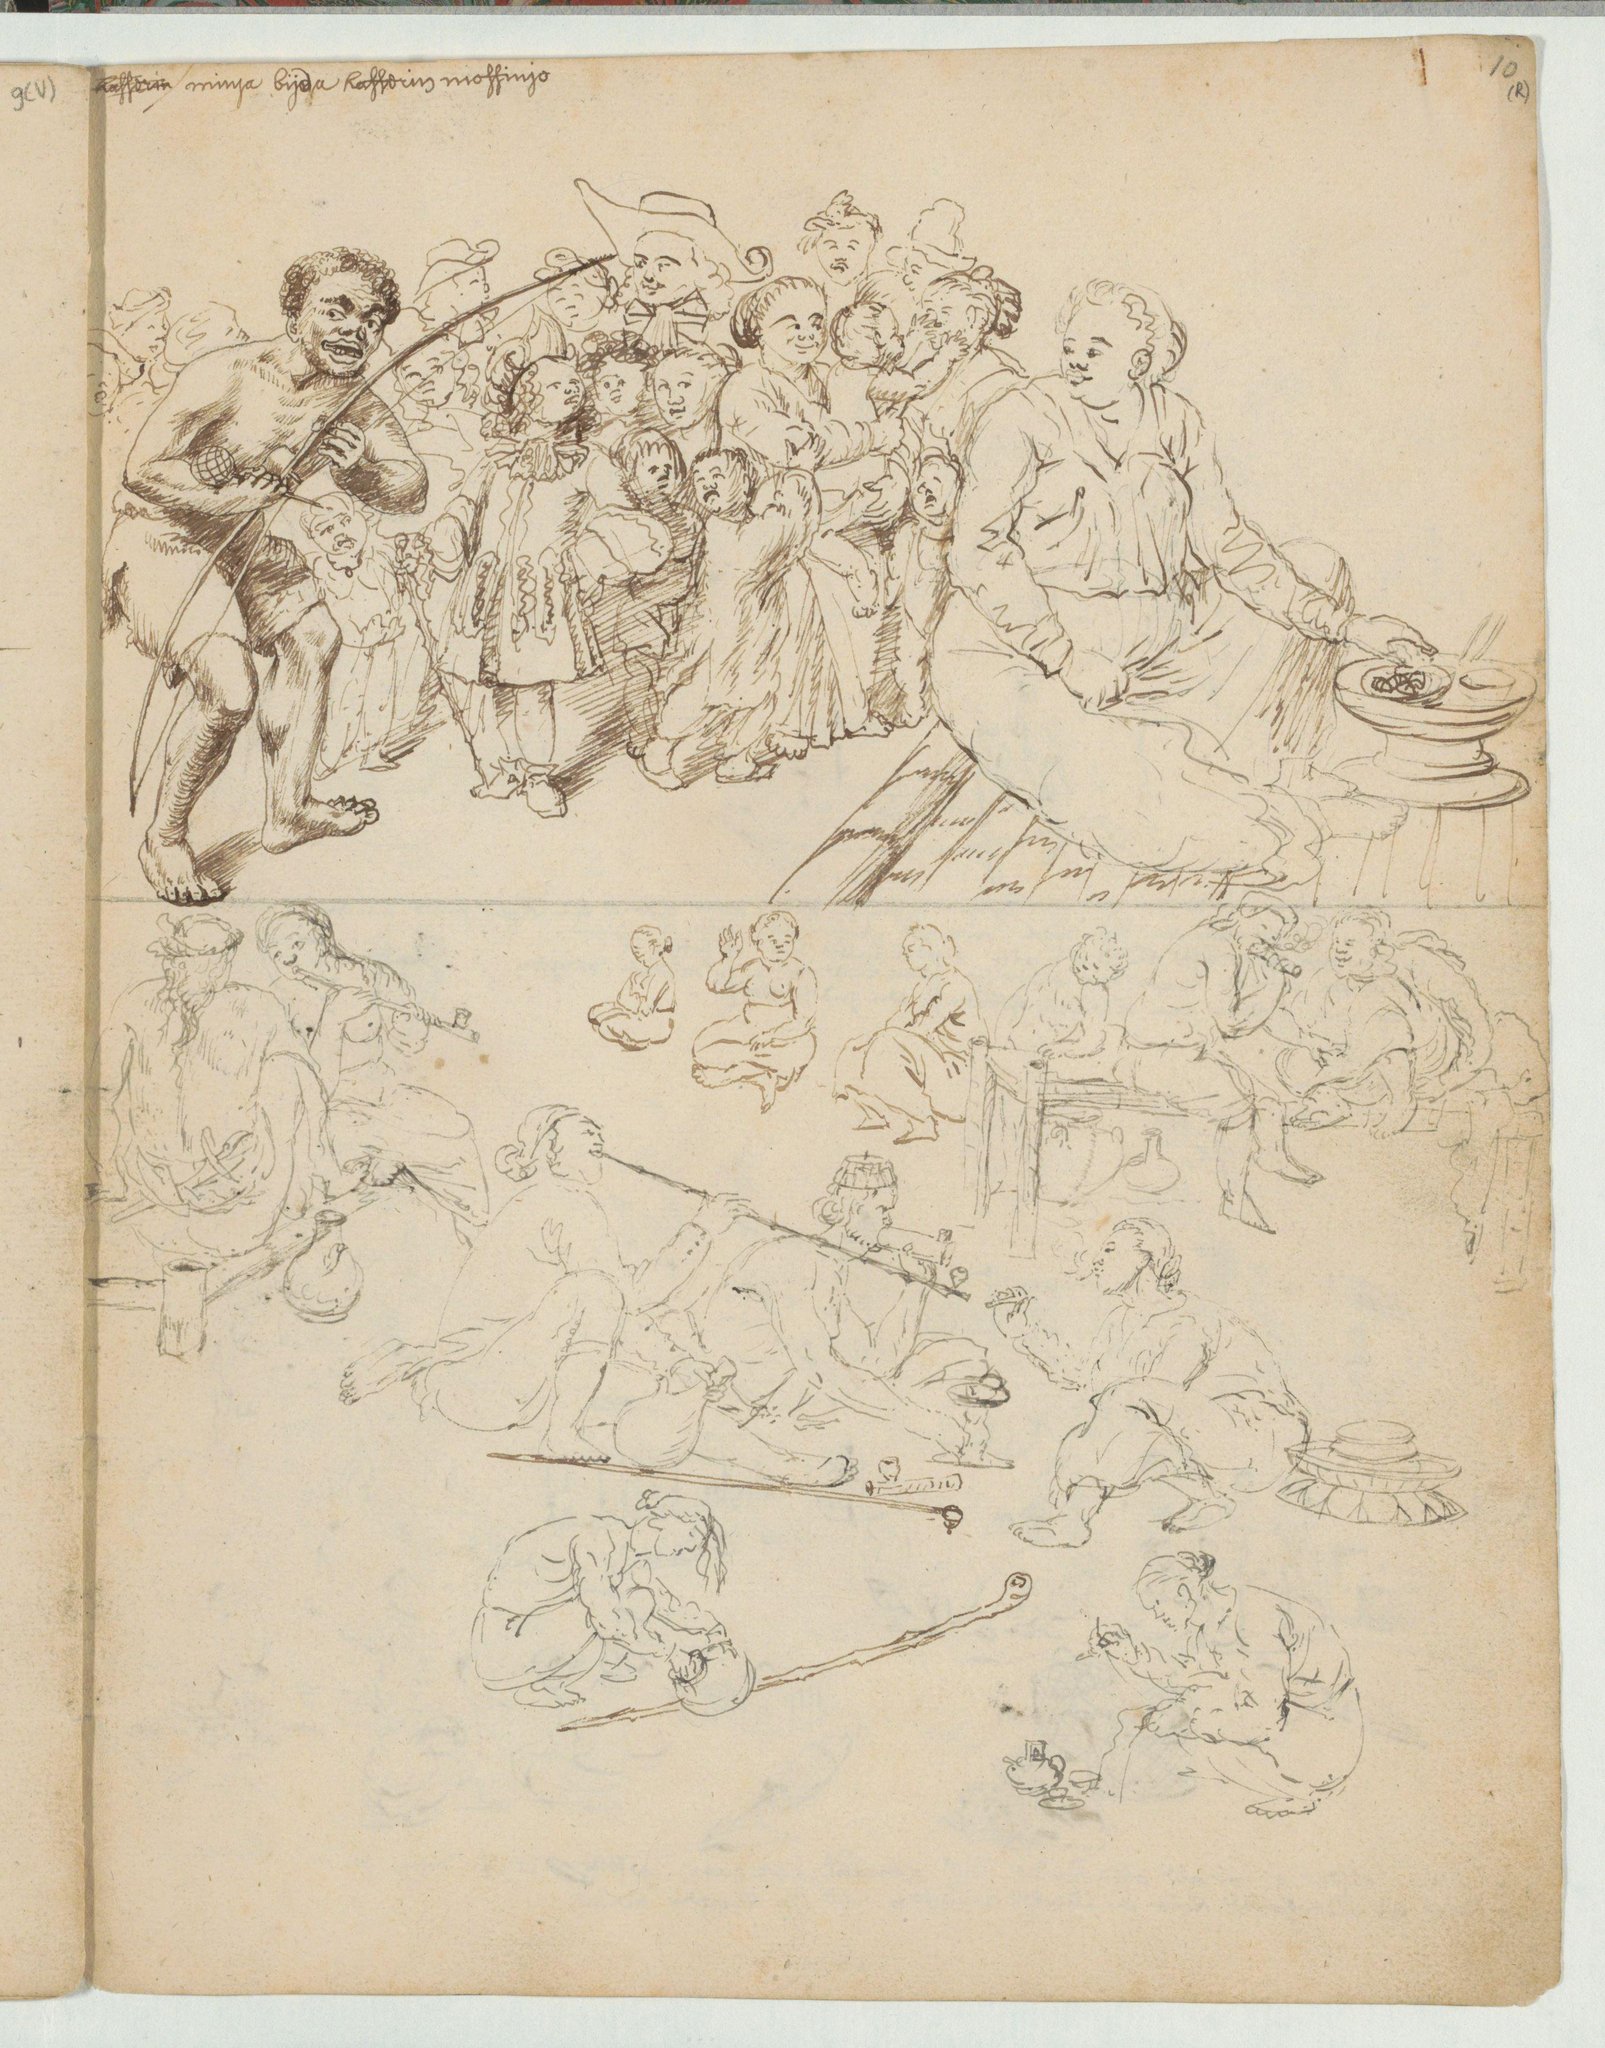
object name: sketchbook leaf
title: Europeanen die naar een Indonesische man kijken en pijprokende figuren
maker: wouter schouten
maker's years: 1638-1704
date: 1660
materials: ink, paper, pencil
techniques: pen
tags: asiatic races and peoples (indonesians), sitting figure, pipe ~ tobacco, archer's weapons: bow, indonesia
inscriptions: annotation: ‘minja bija [...] moffinjo’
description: De indonesiche man heeft een boog in de hand. Blad 10 recto van een katern van 10 bladen afkomstig uit een schetsboek.